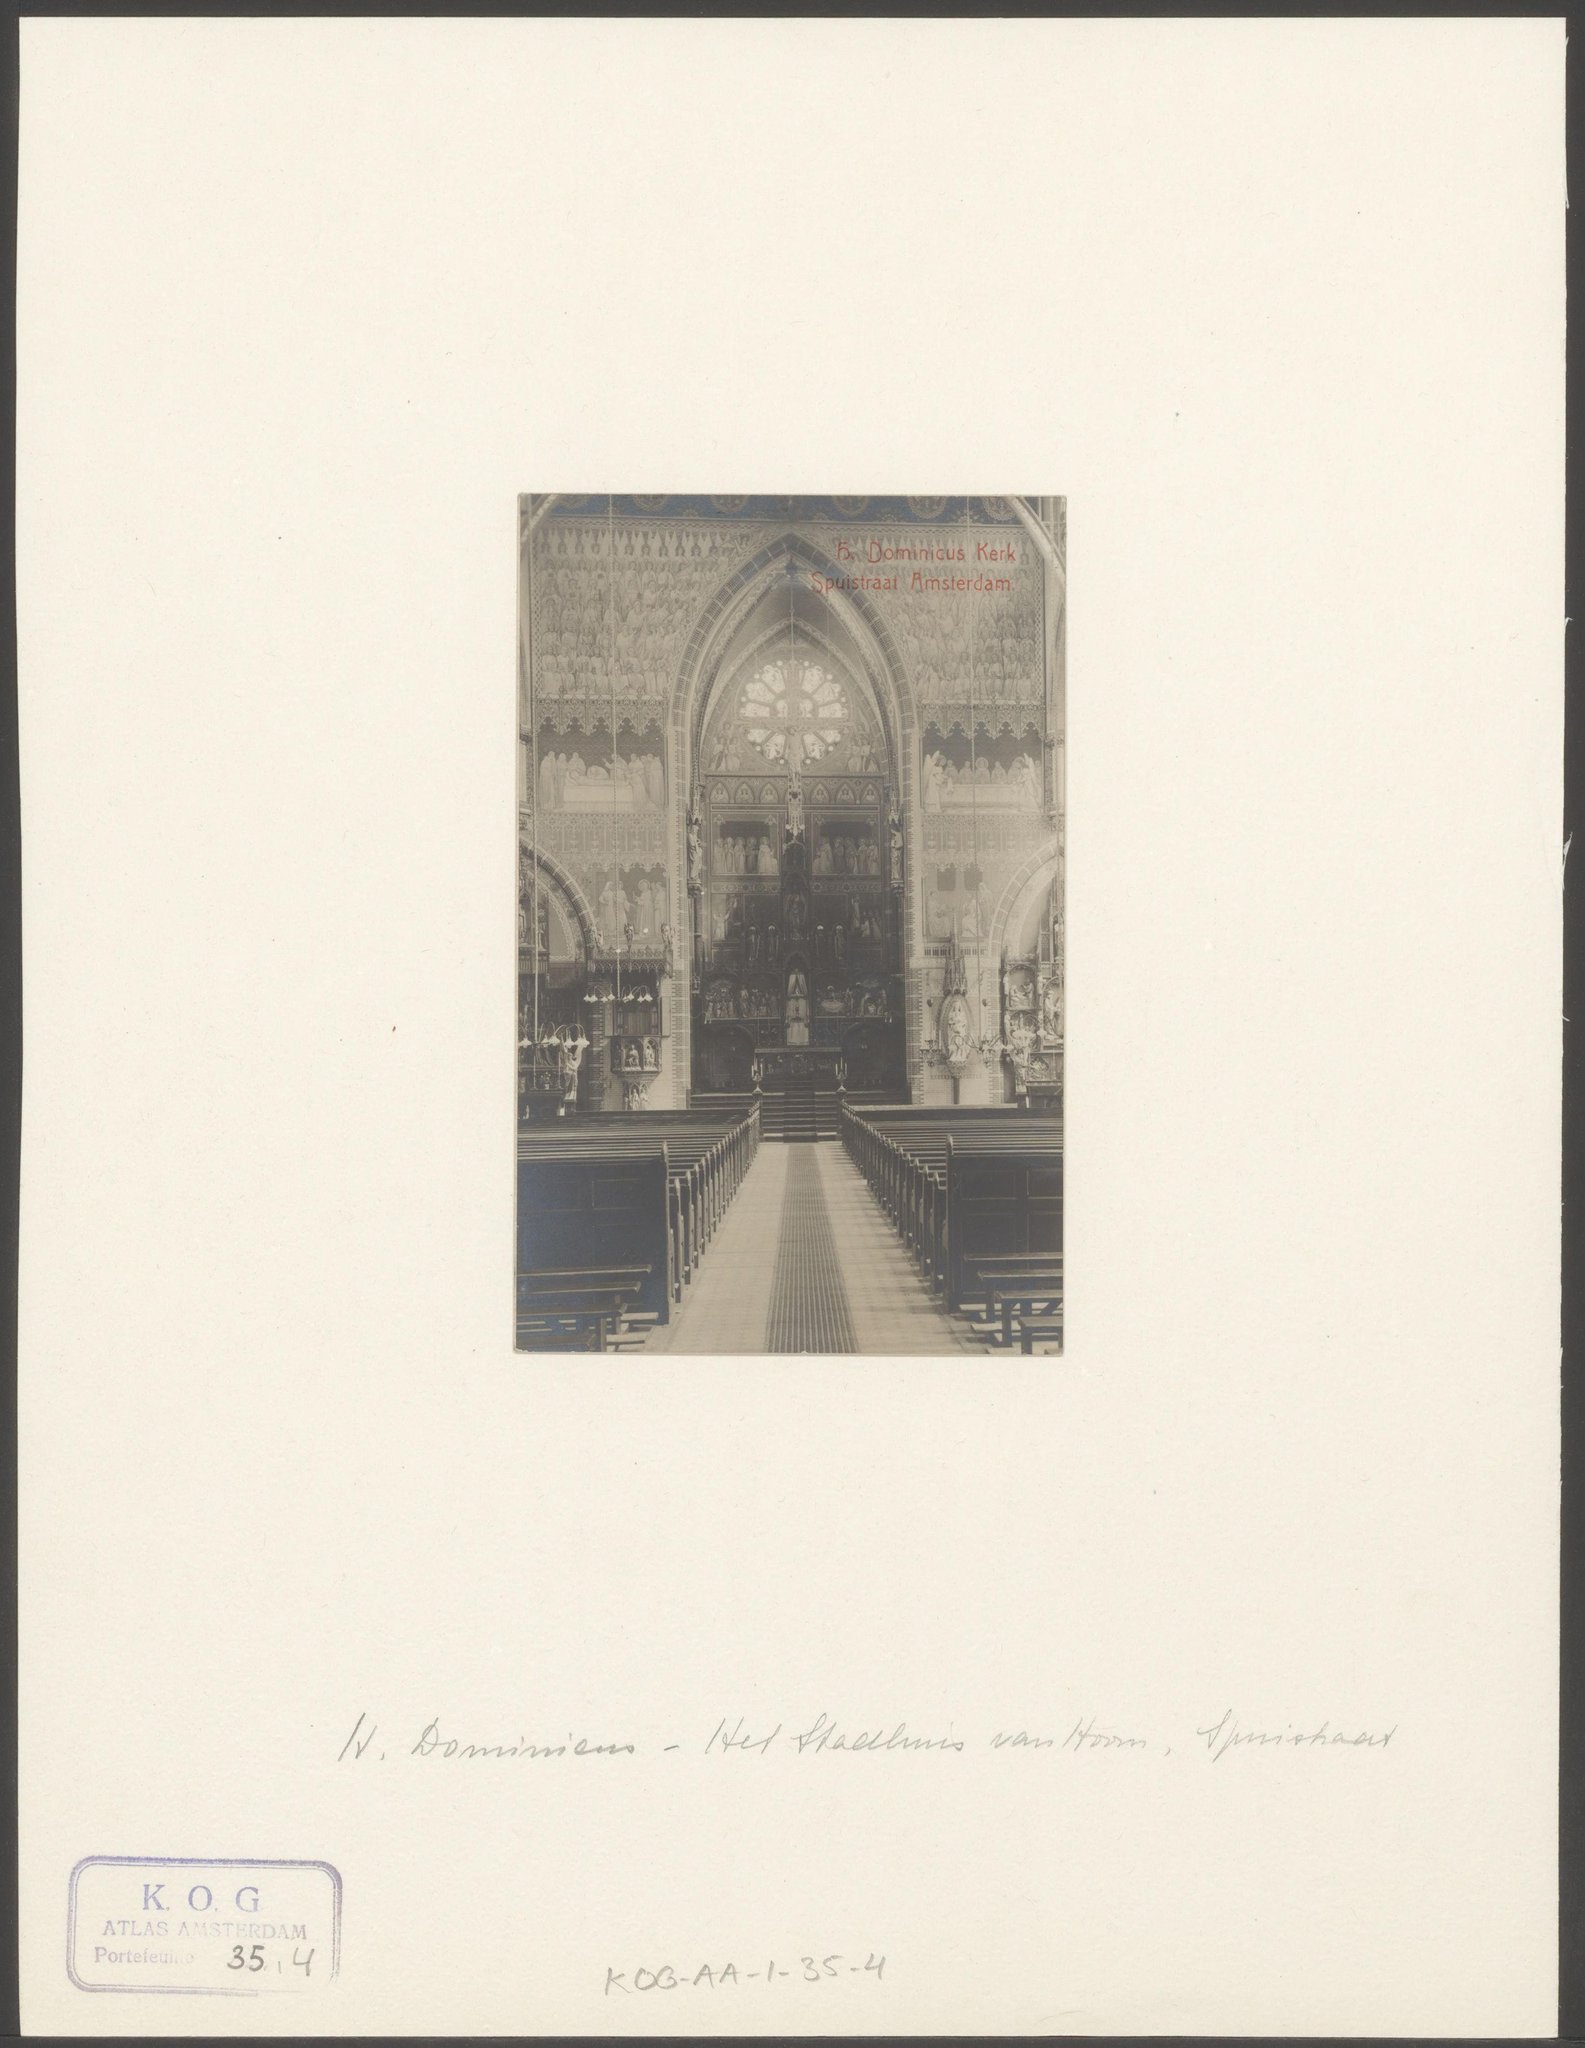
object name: photograph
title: Gezicht op het koor van de Dominicuskerk te Amsterdam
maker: Anonymous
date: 1900-1930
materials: paper, cardboard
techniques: gelatin silver print, letterpress printing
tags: roman catholic church, parts of church interior: choir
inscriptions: collector's mark: ‘17’ Lugt 1641b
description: Ook wel bekend als De Pool. Onderwerpsrubriek binnen de Atlas Amsterdam: R.K. Gemeenten: Sint Nicolaaskerk t/m Willibrordus (Rustenburgerstraat).